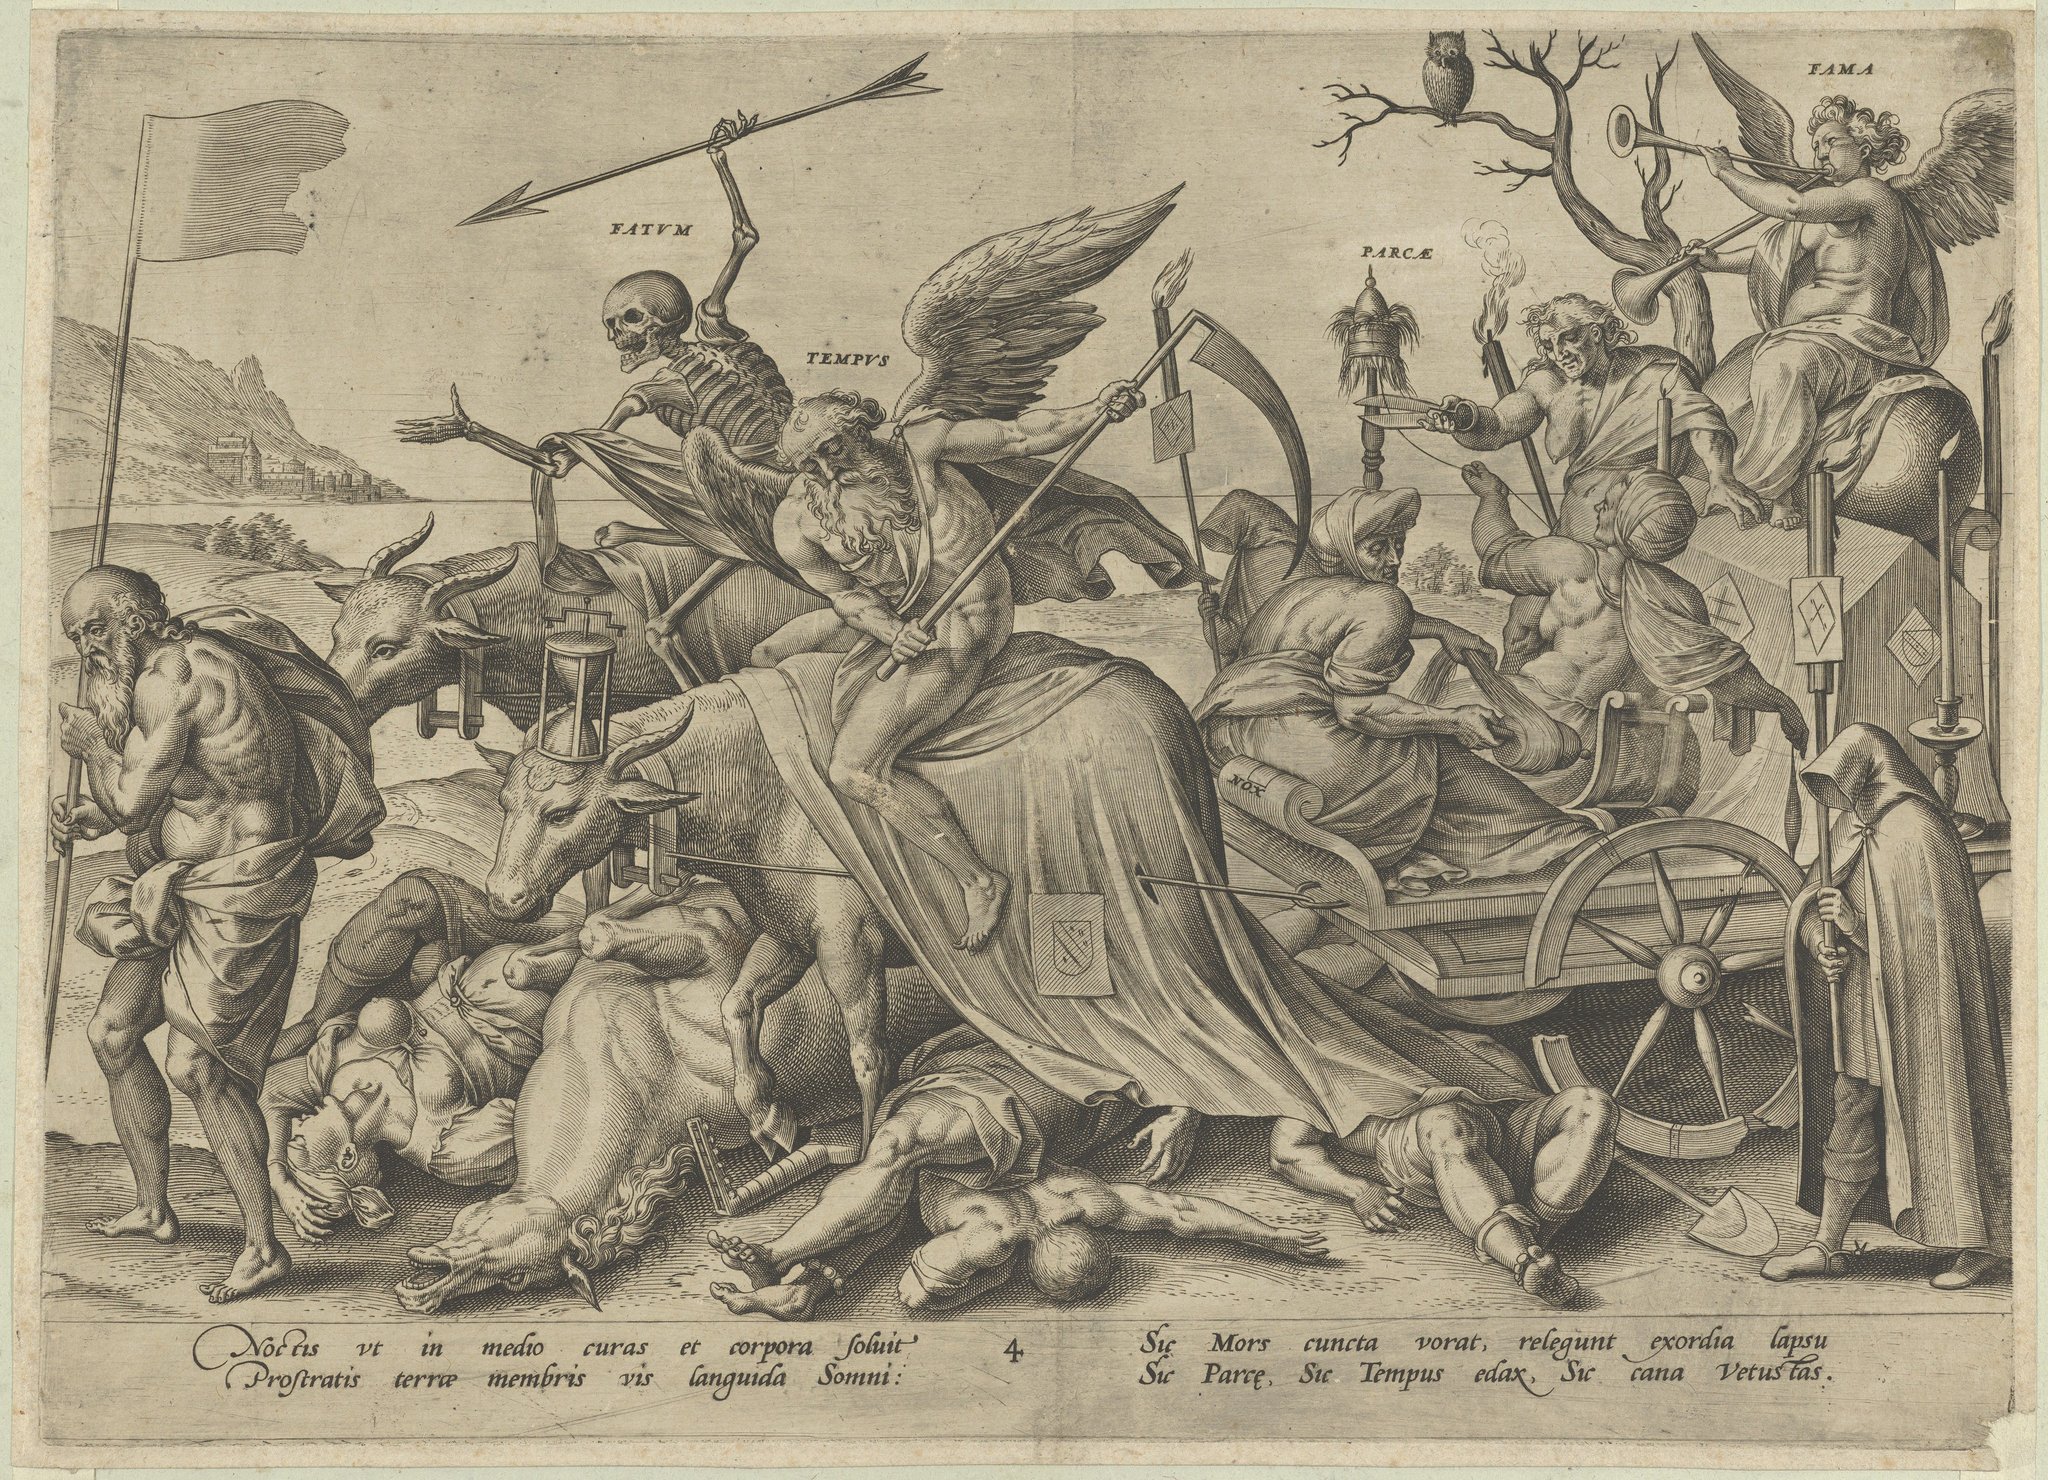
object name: print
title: Old Age (Night), from "The Four Ages of Man and Death with the Last Judgment"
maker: hieronymus wierix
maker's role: artist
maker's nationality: netherlandish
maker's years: 1553-1619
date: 1619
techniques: engraving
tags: human figures,weapons,angels,last judgement